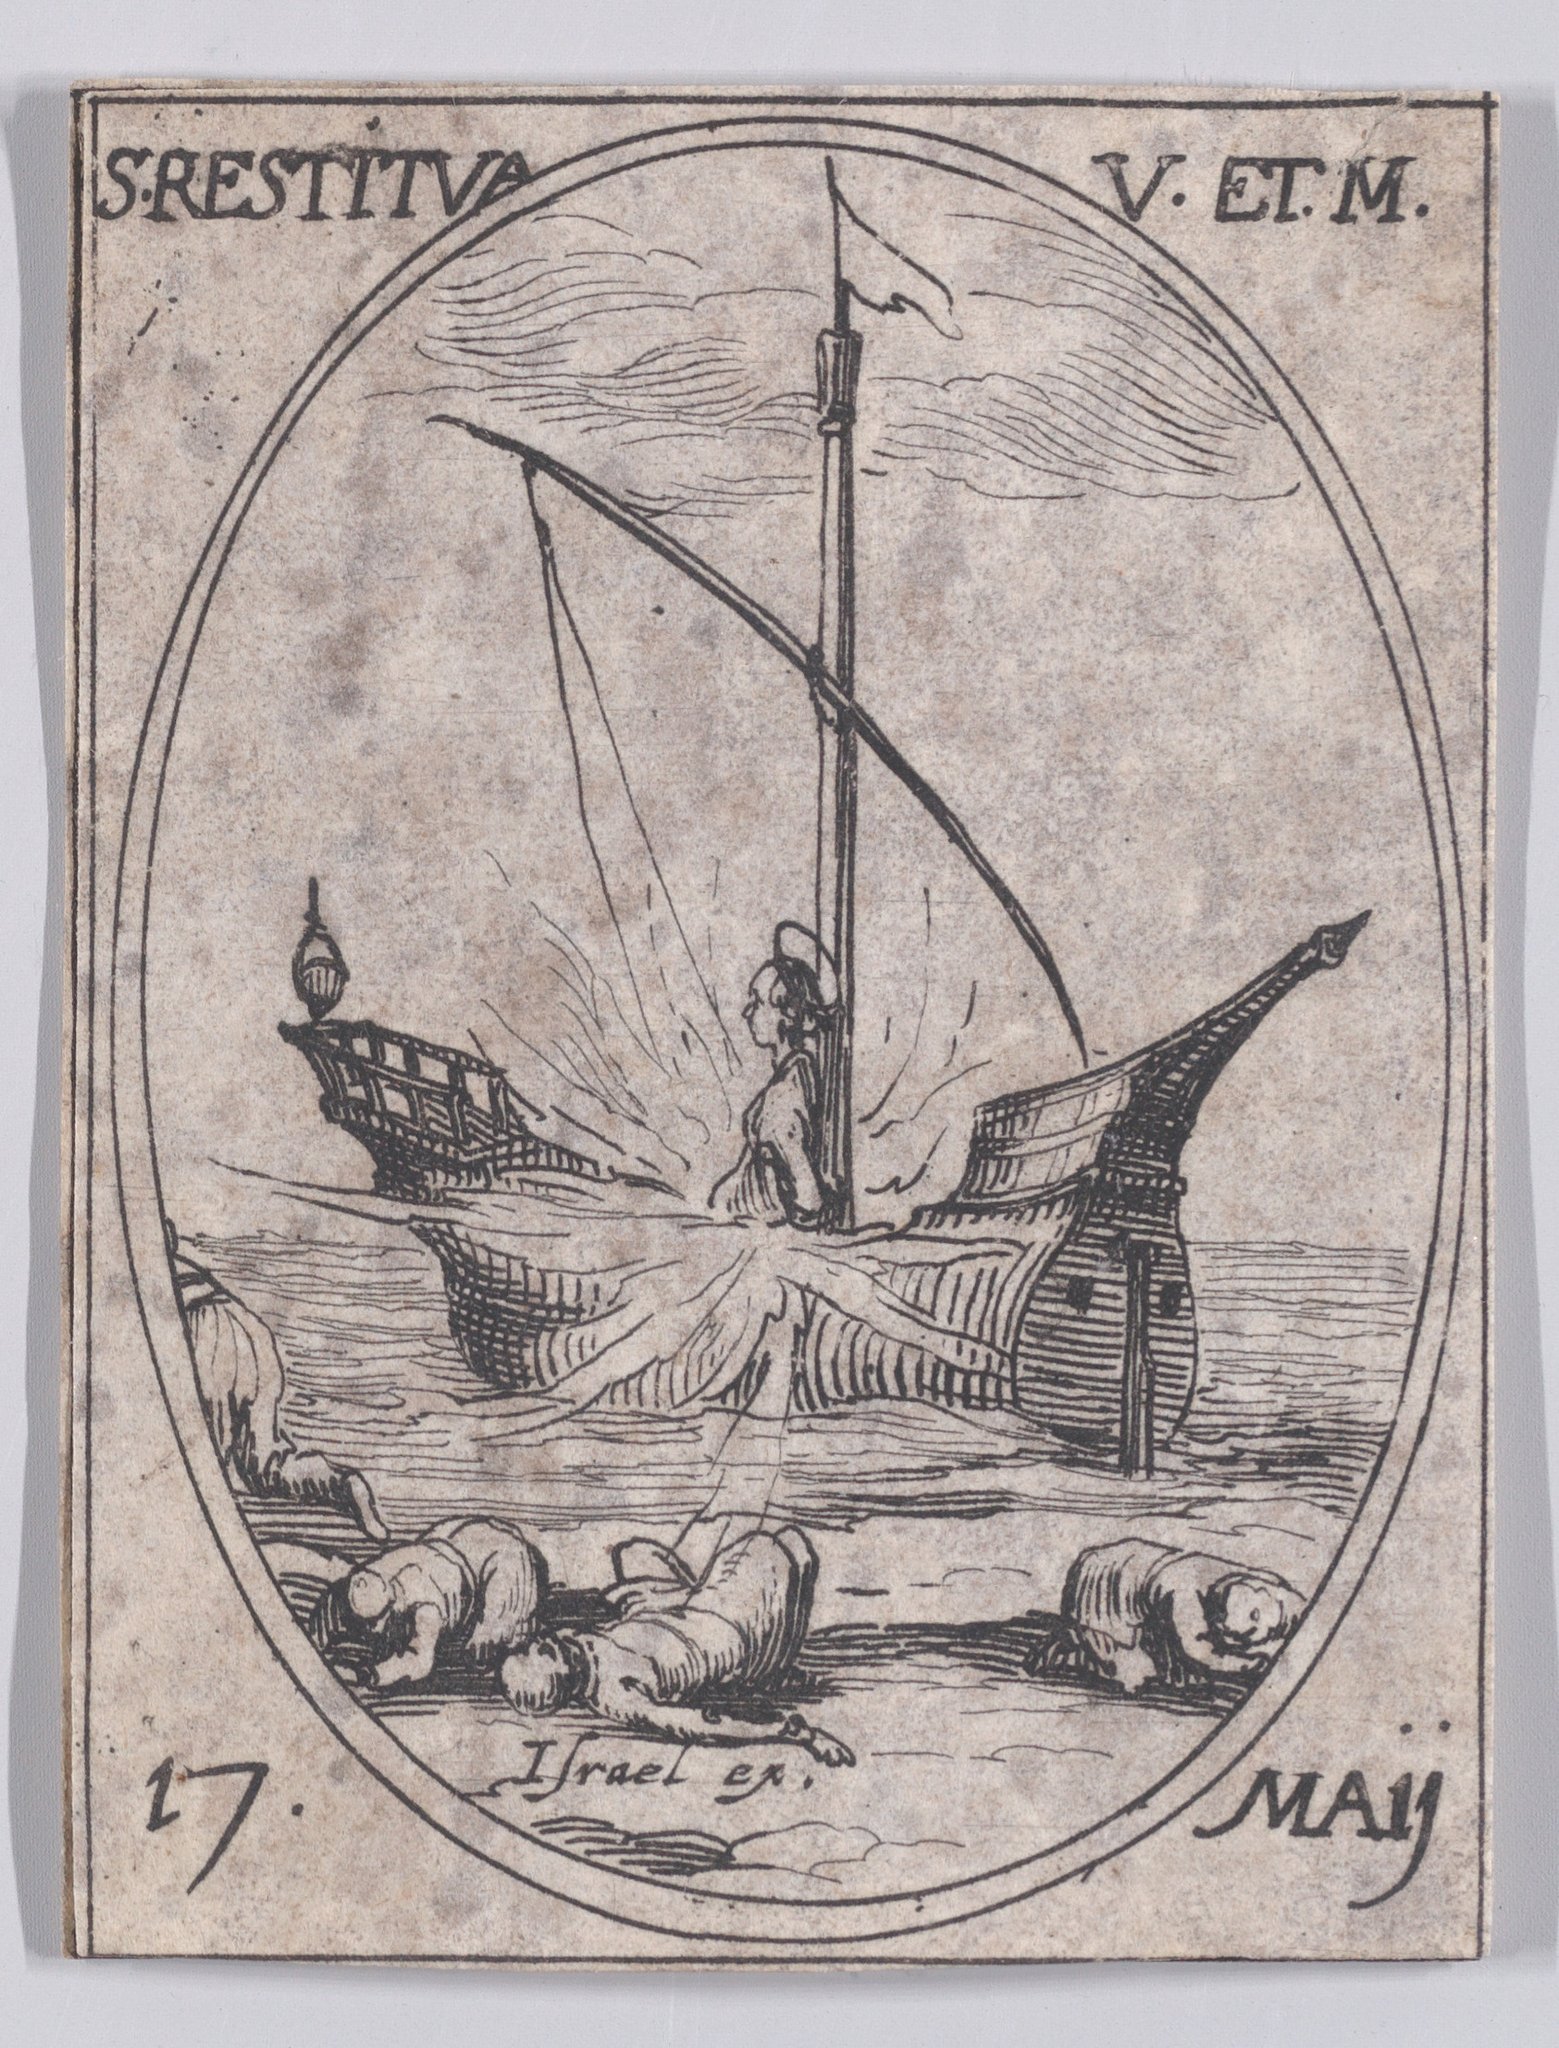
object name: print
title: Ste. Restitue, vierge et martyre (St. Restituta, Virgin and Martyr), May 17th, from "Les Images De Tous Les Saincts et Saintes de L'Année" (Images of All of the Saints and Religious Events of the Year)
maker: jacques callot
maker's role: artist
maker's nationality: french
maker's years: 1592-1635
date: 1636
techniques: etching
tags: women,saints,boats